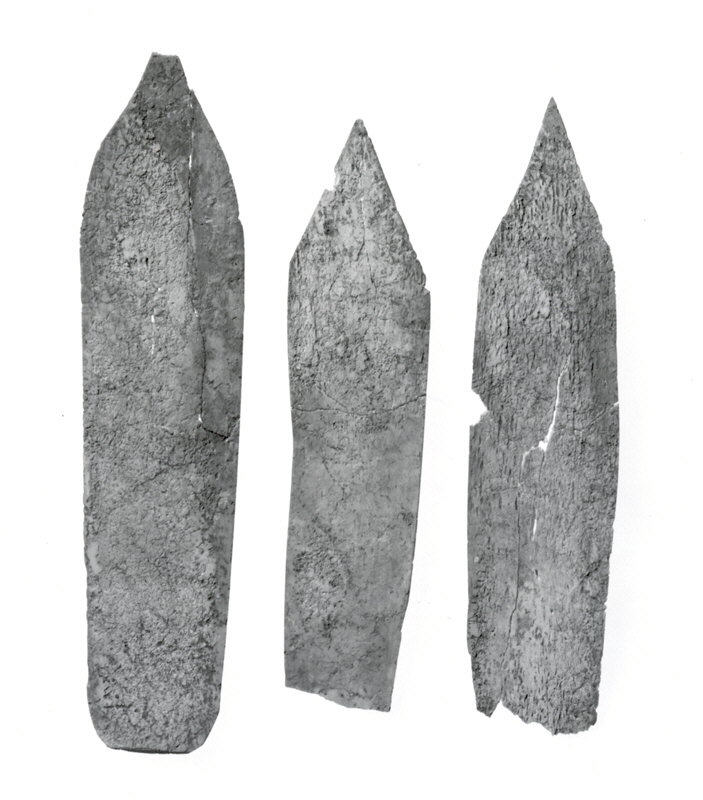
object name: spatula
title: Spatulae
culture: edomite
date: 1000-800 BCE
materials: bone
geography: levant